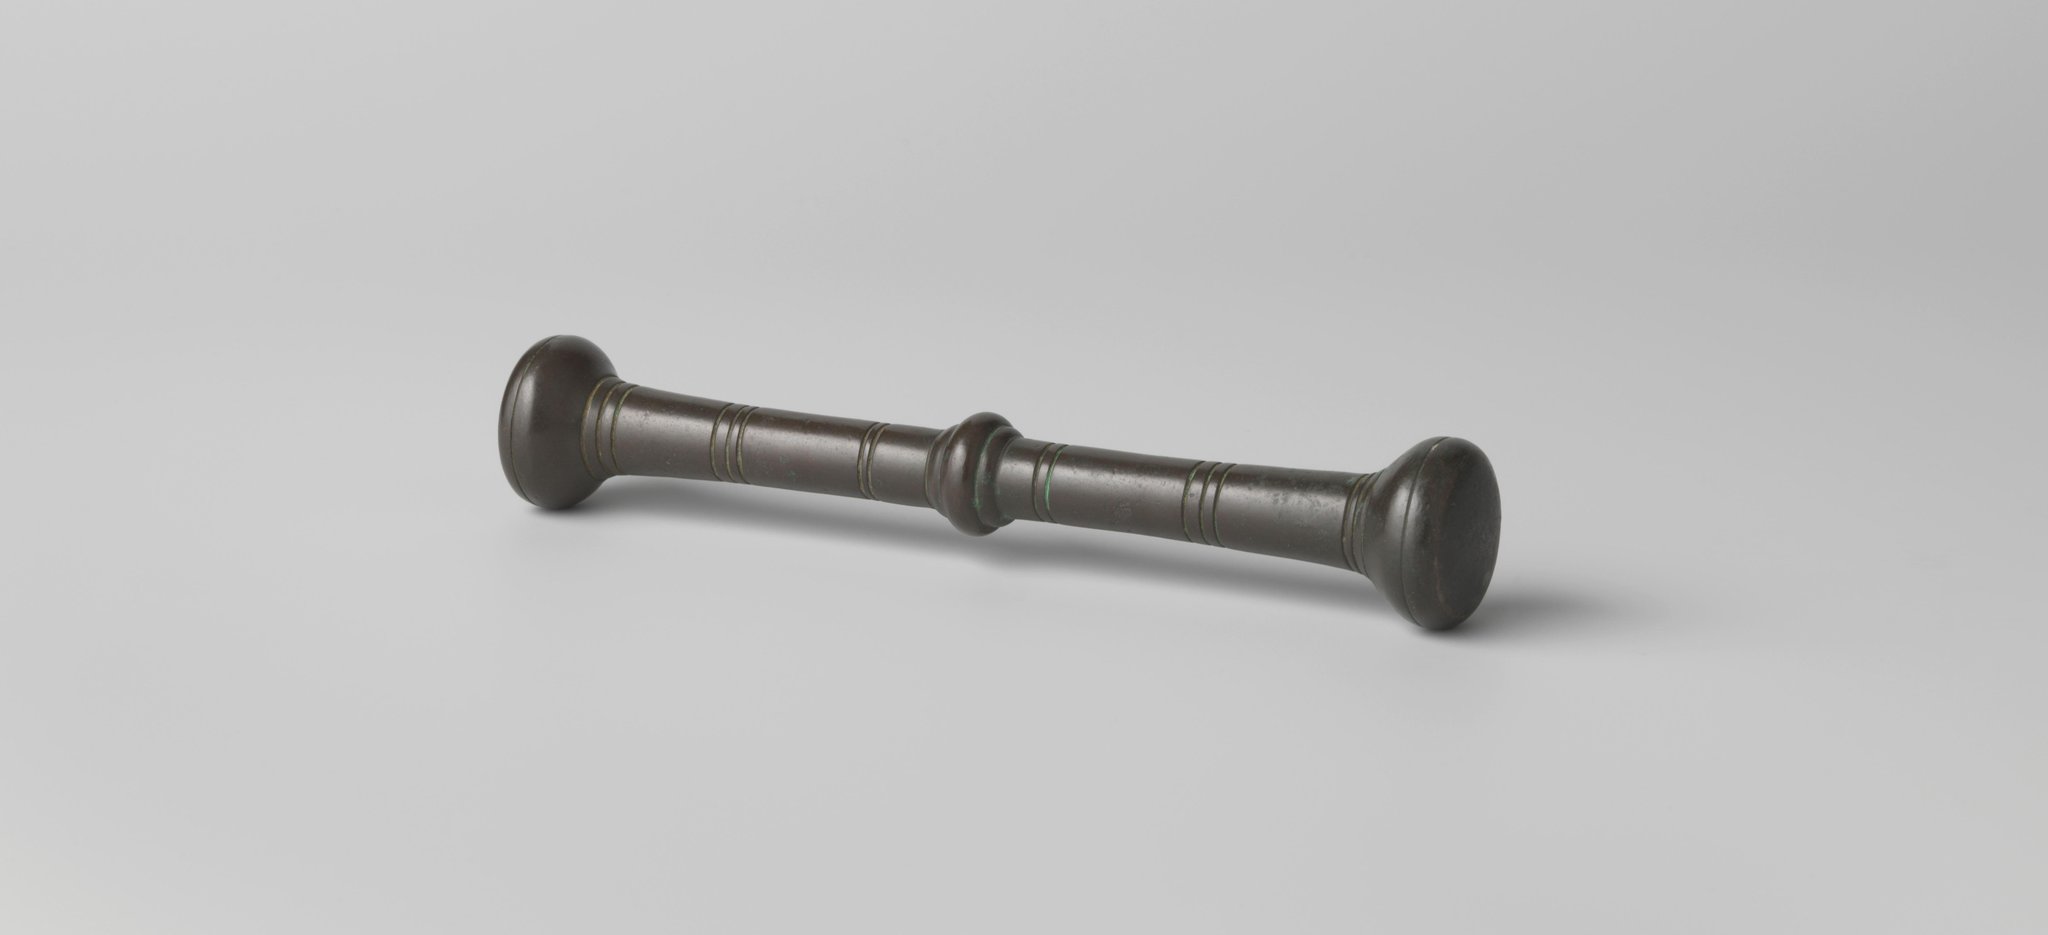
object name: beater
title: Stamper van brons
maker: henrick ter horst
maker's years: 1600-1680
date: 1622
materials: bronze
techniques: casting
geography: deventer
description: Mortar and pestle with inscription: LOF GODT VAN AL (Praise God above all) Ao 1622. Bronze. Deventer, 1622.